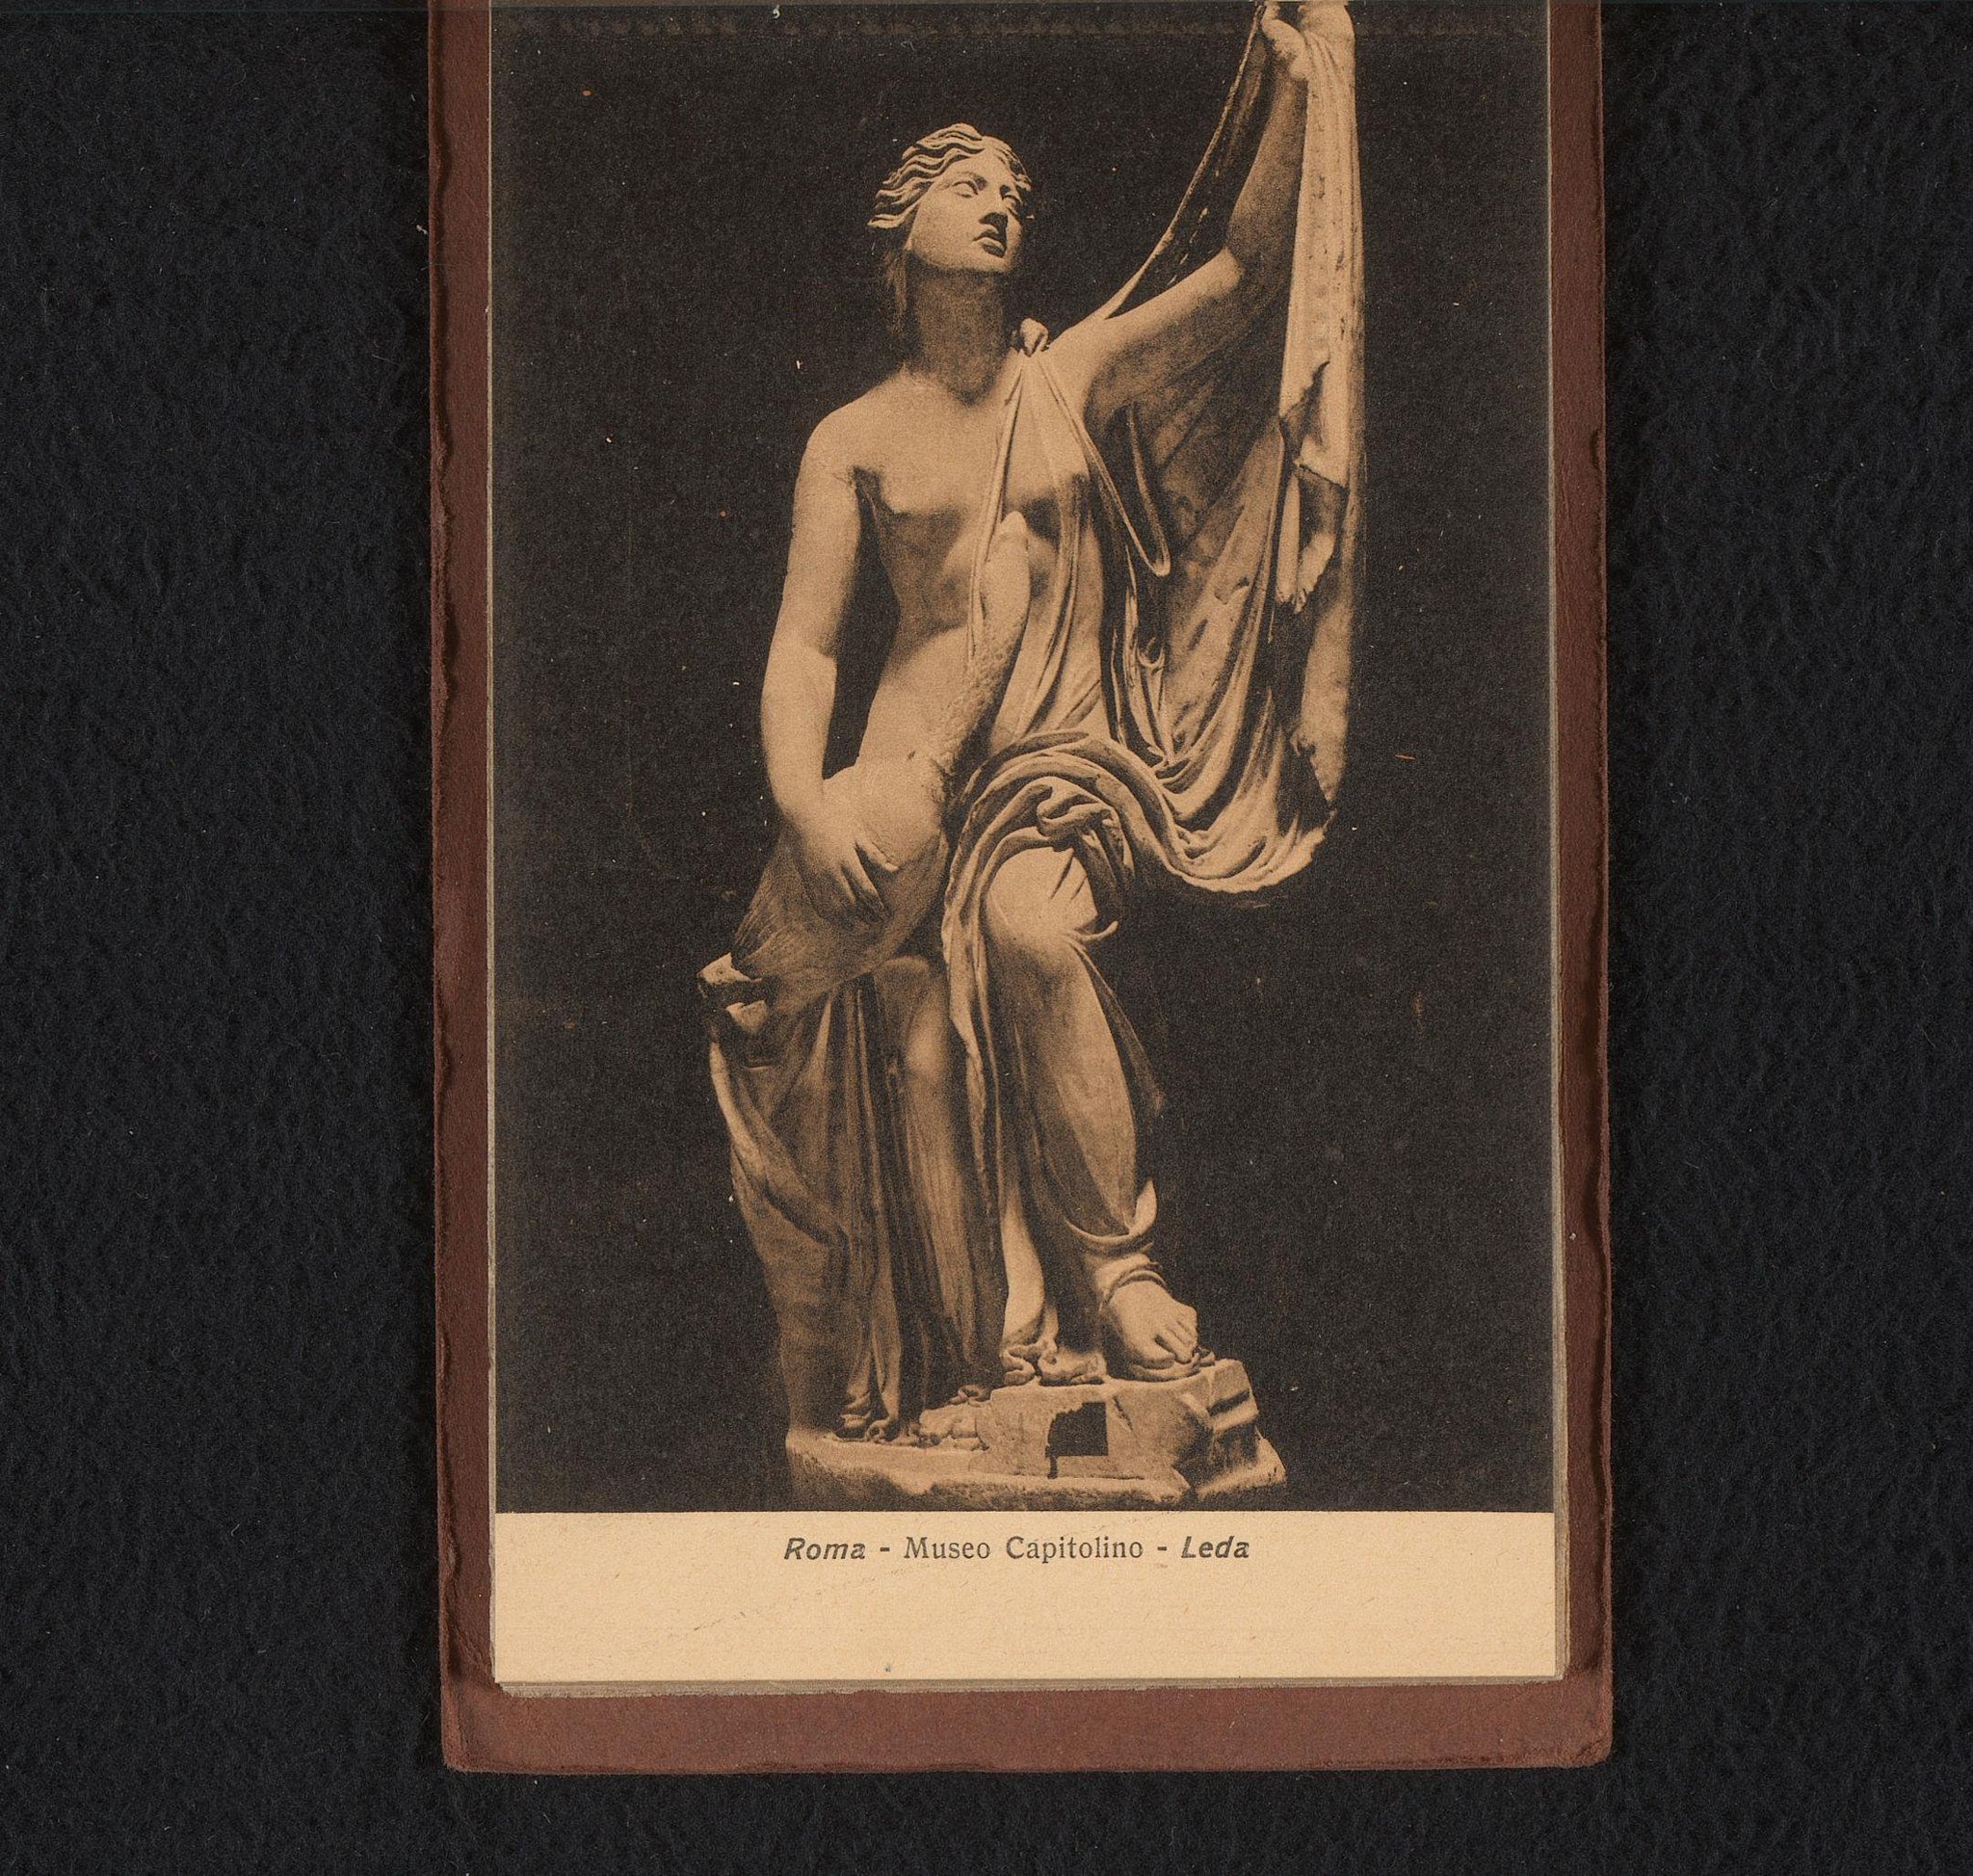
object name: photomechanical print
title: Roma - Museo Capitolino - Leda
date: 1905-1930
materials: cardboard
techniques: photograph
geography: rome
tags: statues, paintings, etc. ~ objects of worship in roman religion, permanent exhibition, museum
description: Prentbriefkaart maakt deel uit van een album.